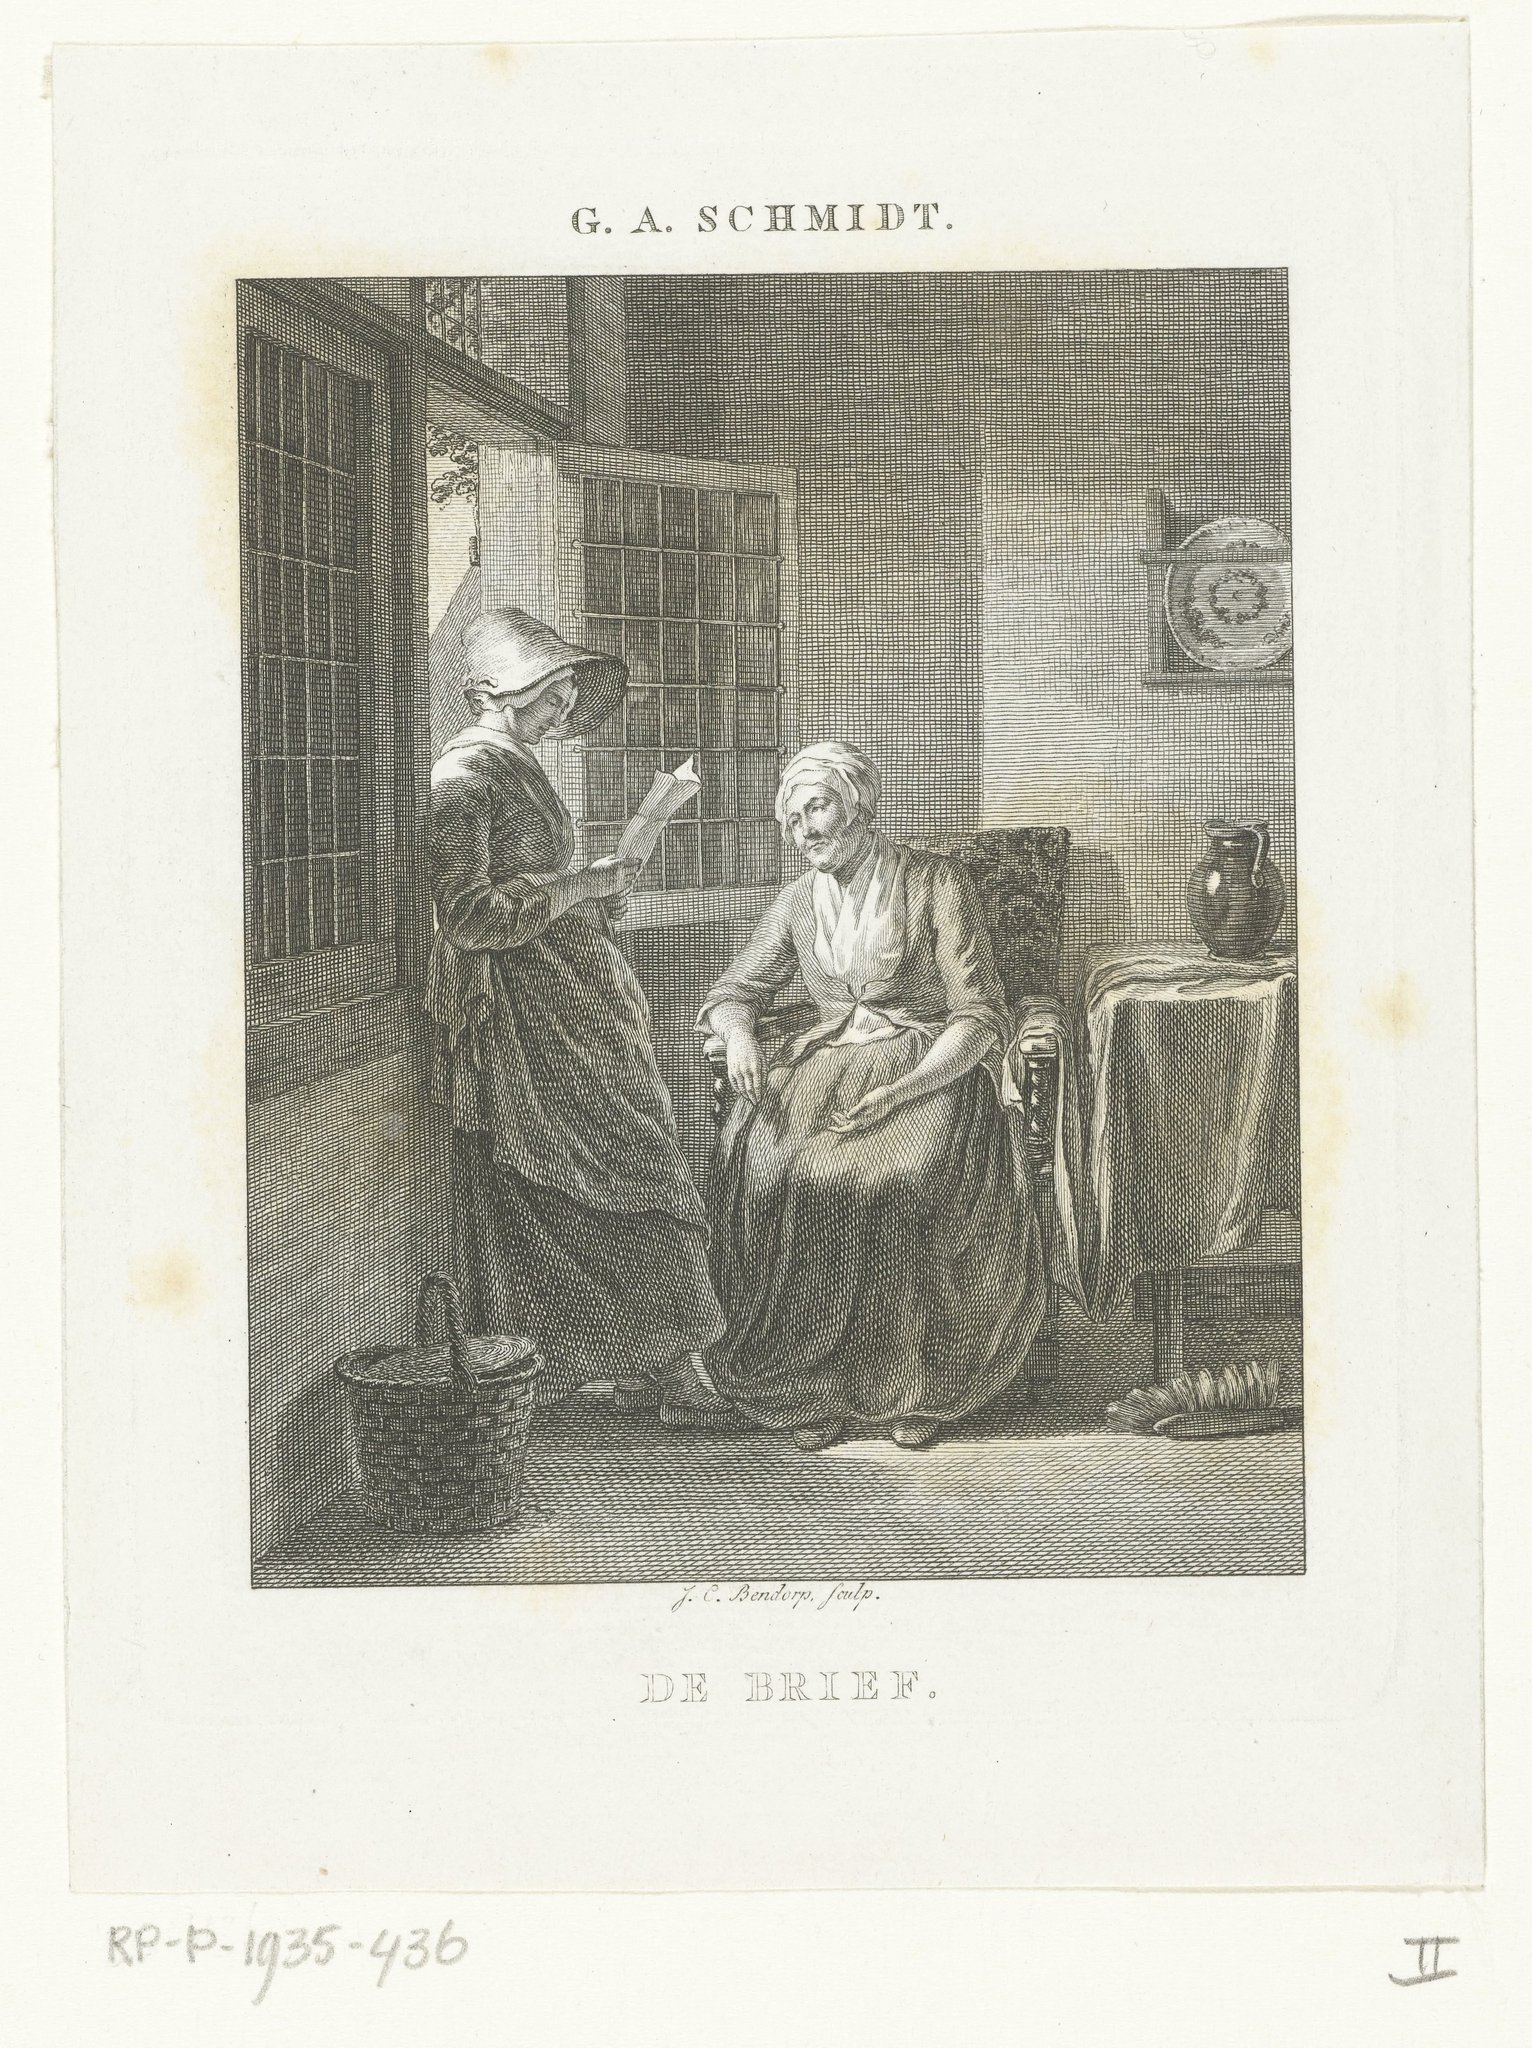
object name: book illustration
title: Jonge vrouw staat bij open raam en leest brief voor aan vrouw op stoel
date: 1776-1847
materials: paper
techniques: engraving, etching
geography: netherlands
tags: open window, reading to somebody, letter, envelope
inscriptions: collector's mark: Lugt 2228, collector's mark: Lugt 2760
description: Prent naar schilderij van George Adam Schmidt. Prent uit: Nederlandsche muzen-almanak, Johannes Immerzeel (uitgever), Amsterdam 1819-1847